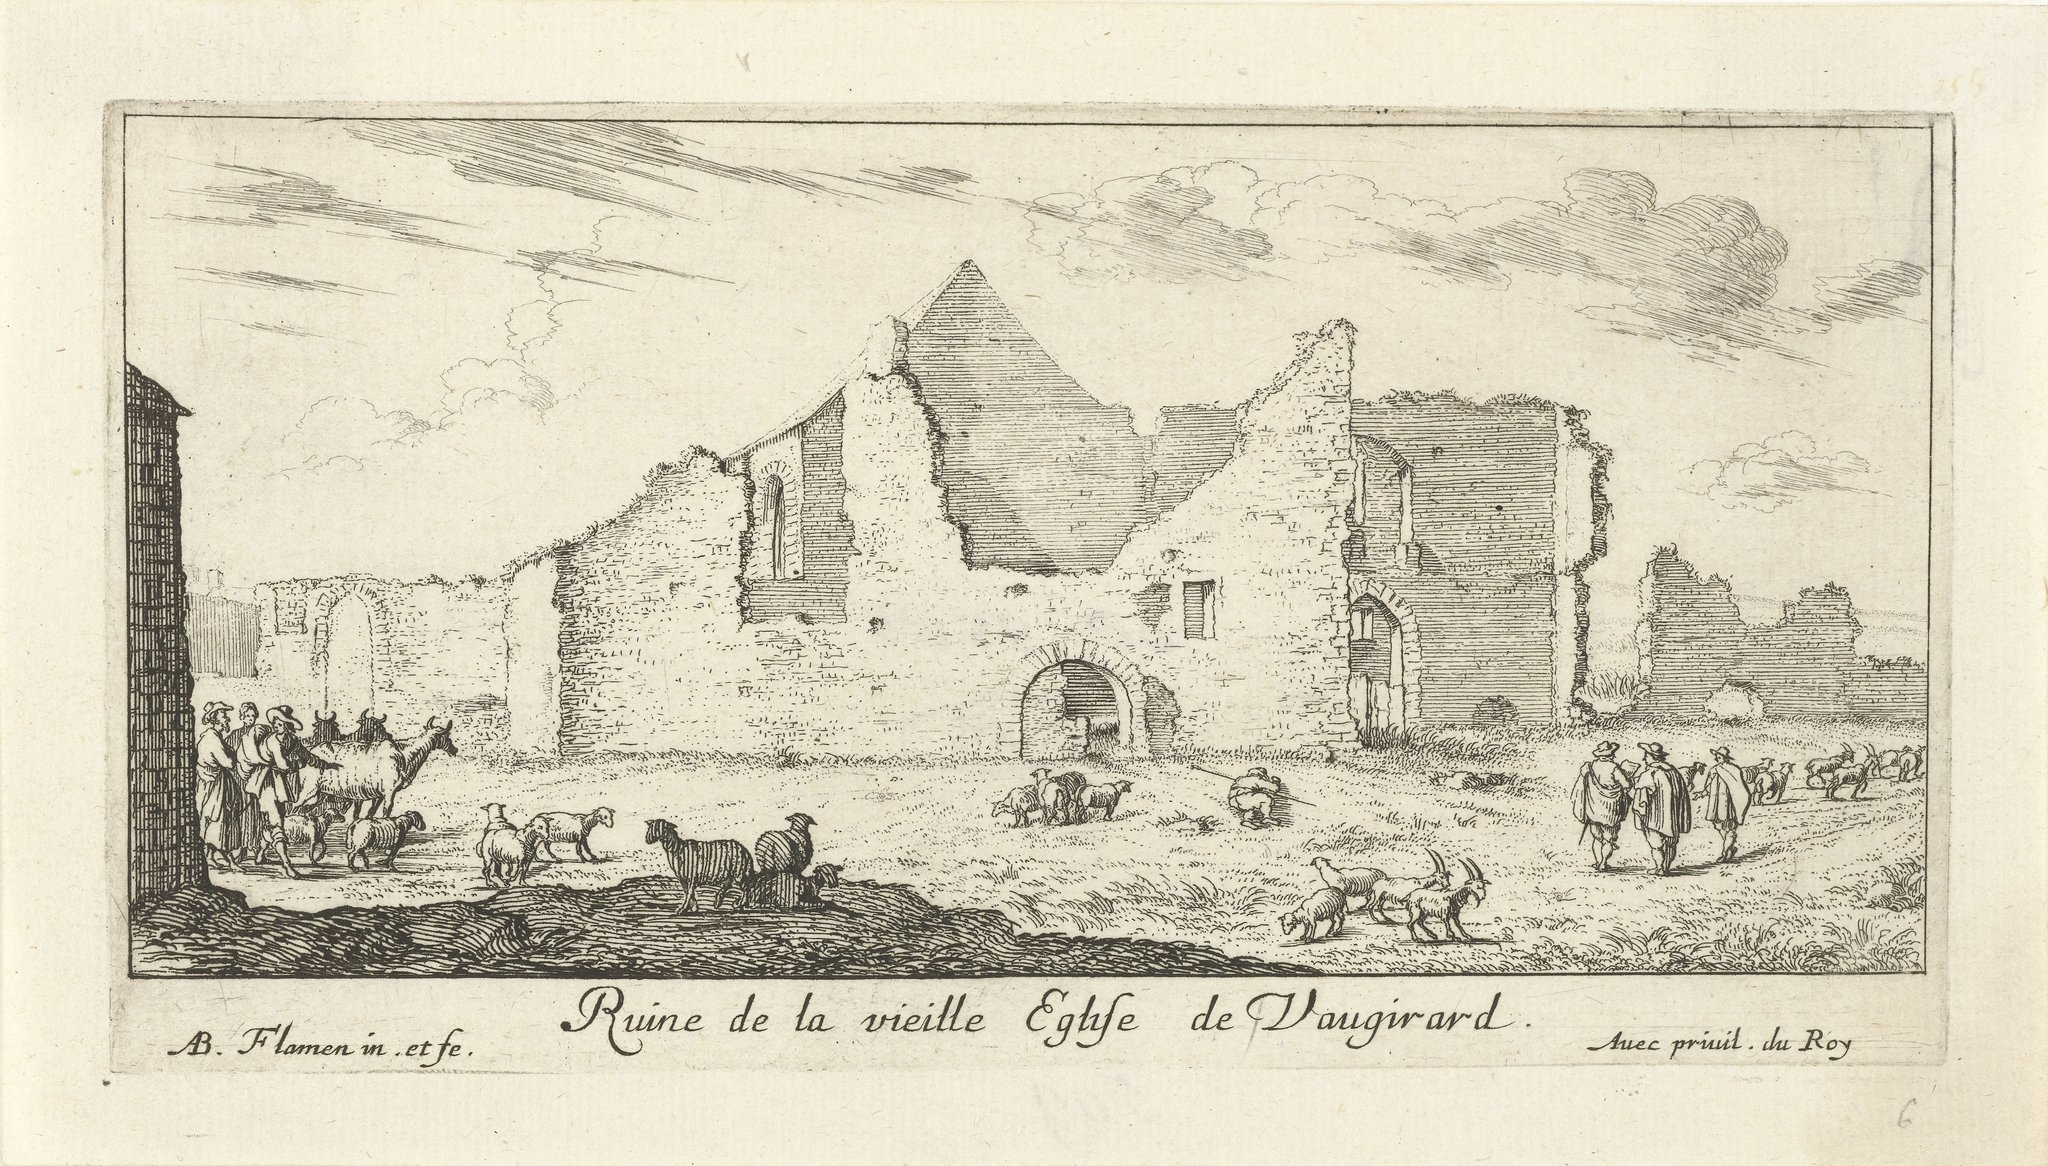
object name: print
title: Ruïne van de Vaugirard kerk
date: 1648-1692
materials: paper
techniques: etching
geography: paris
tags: landscape with ruins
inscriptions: collector's mark: Lugt 2161, collector's mark: Lugt 2228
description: Gezicht op de ruïne van de Vaugirard kerk met op de voorgrond koeien, schapen en wandelaars.